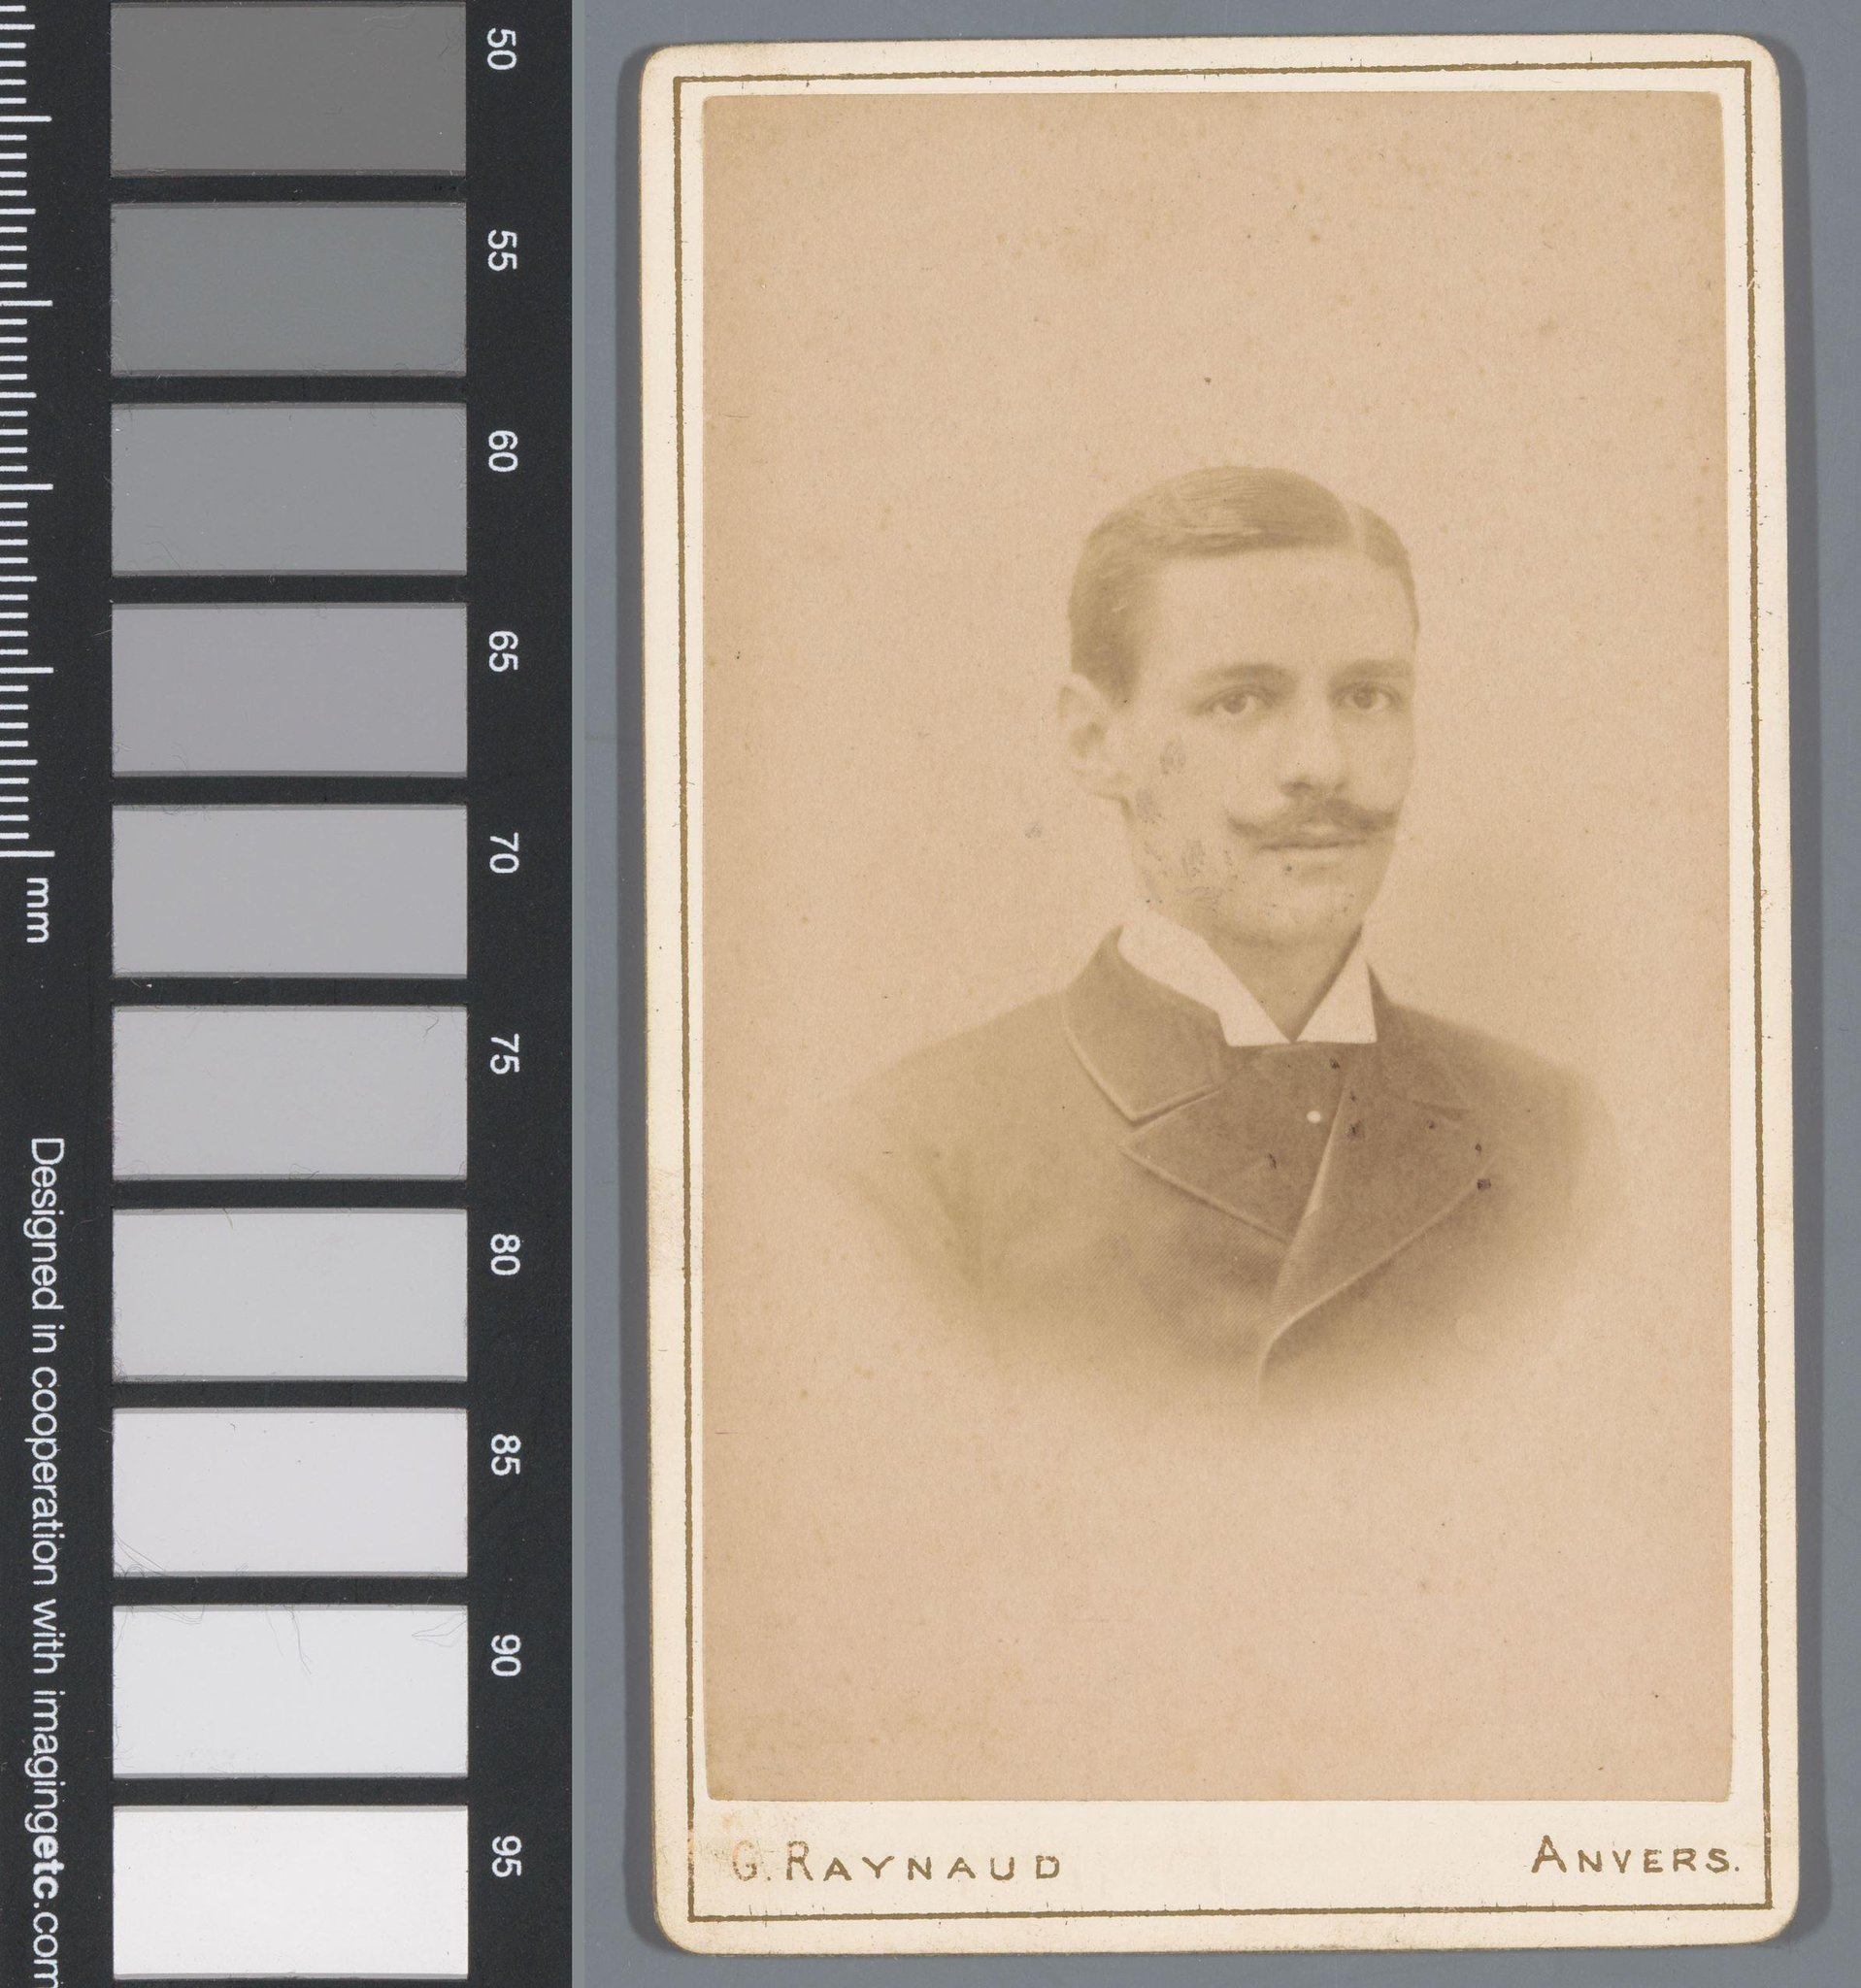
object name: carte de visite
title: Portret van een onbekende man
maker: georges raynaud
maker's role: fotograaf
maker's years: 1847-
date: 1882-1902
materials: cardboard, paper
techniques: albumen print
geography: antwerp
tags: adult man, historical persons